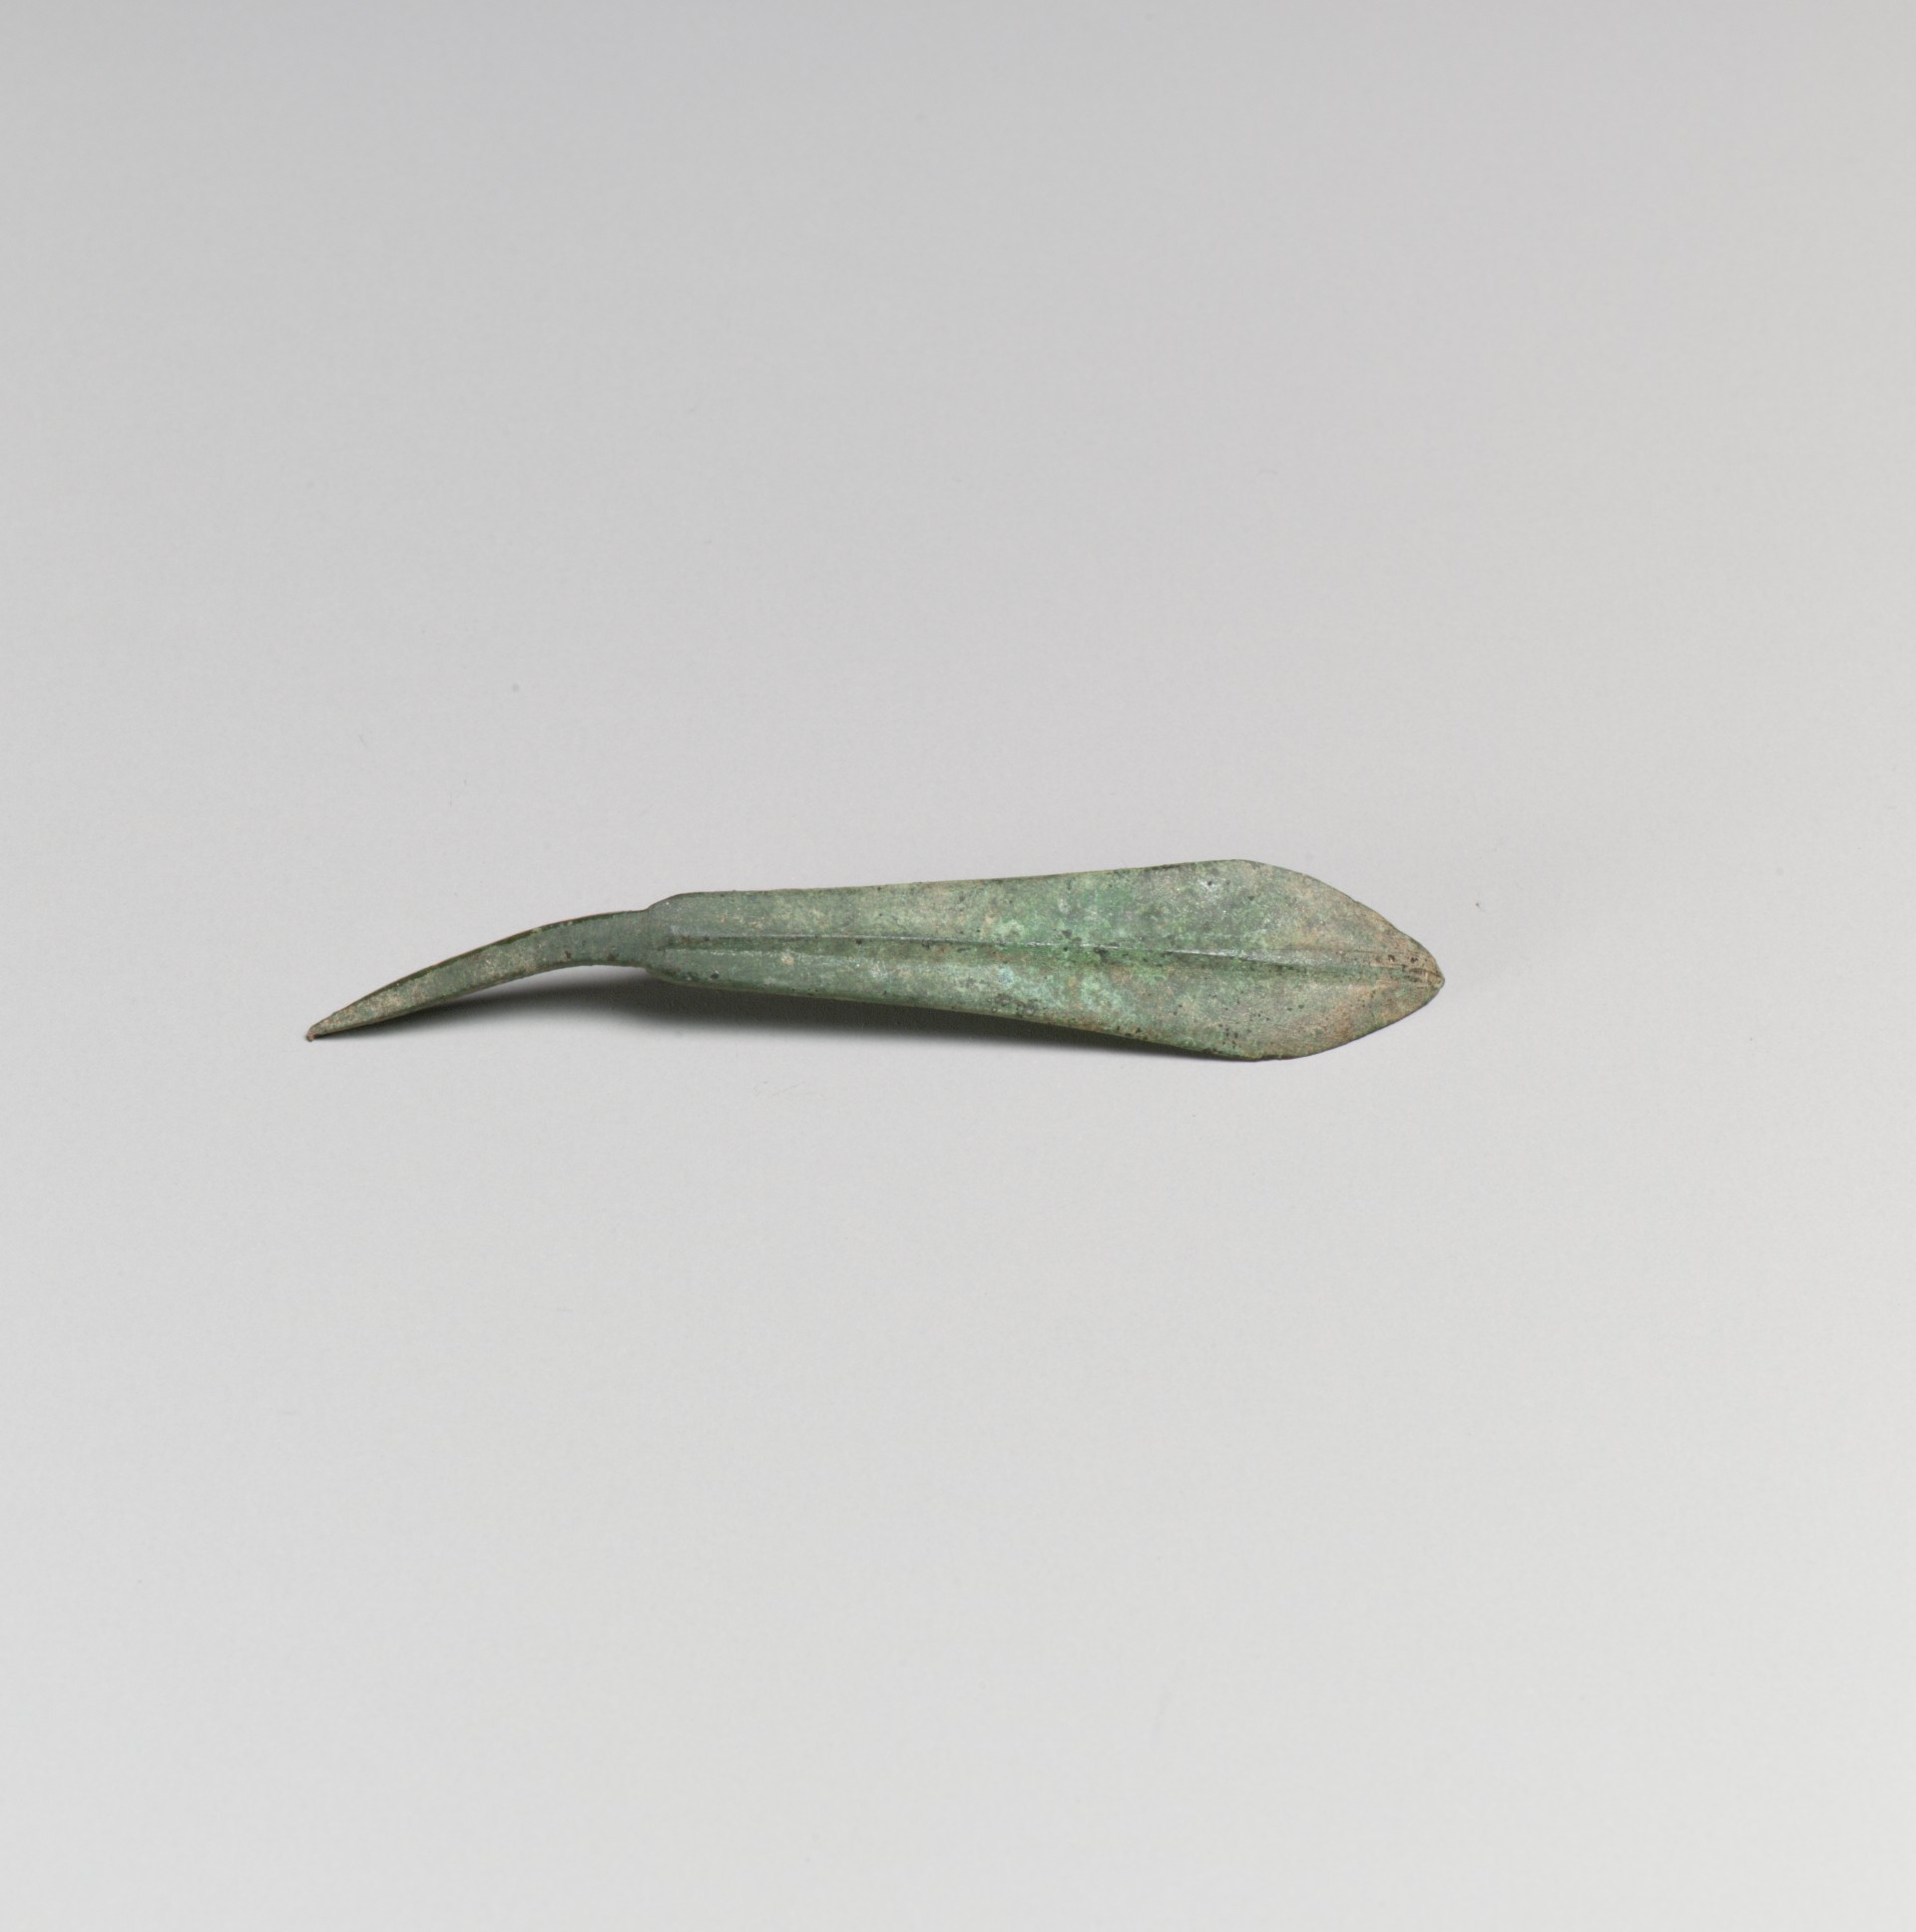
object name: arrowhead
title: Bronze arrowhead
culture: achaemenid or greek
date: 400-501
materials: bronze